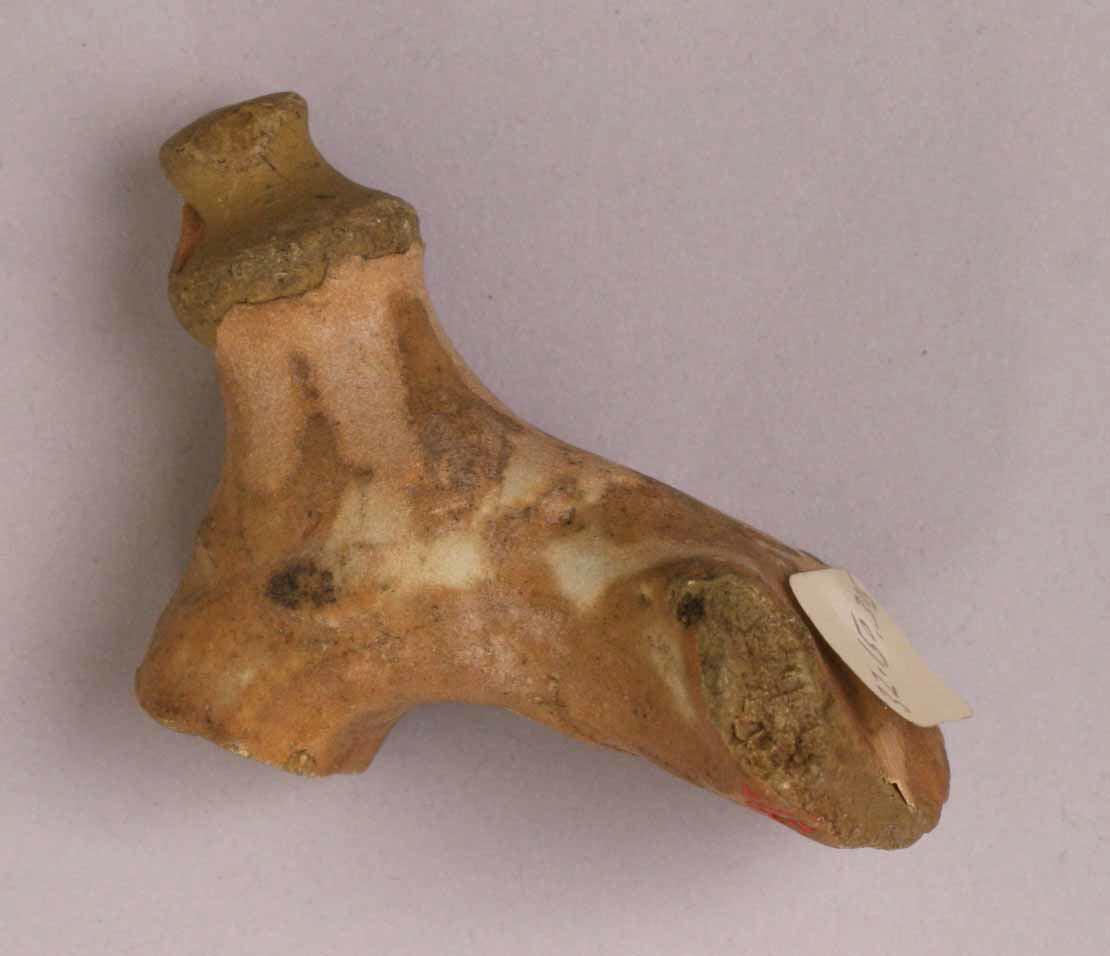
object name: fragment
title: Fragment of a Luster-Painted Handle with Thumb Rest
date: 801-1100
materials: earthenware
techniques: glazing, luster painting, molding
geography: iraq